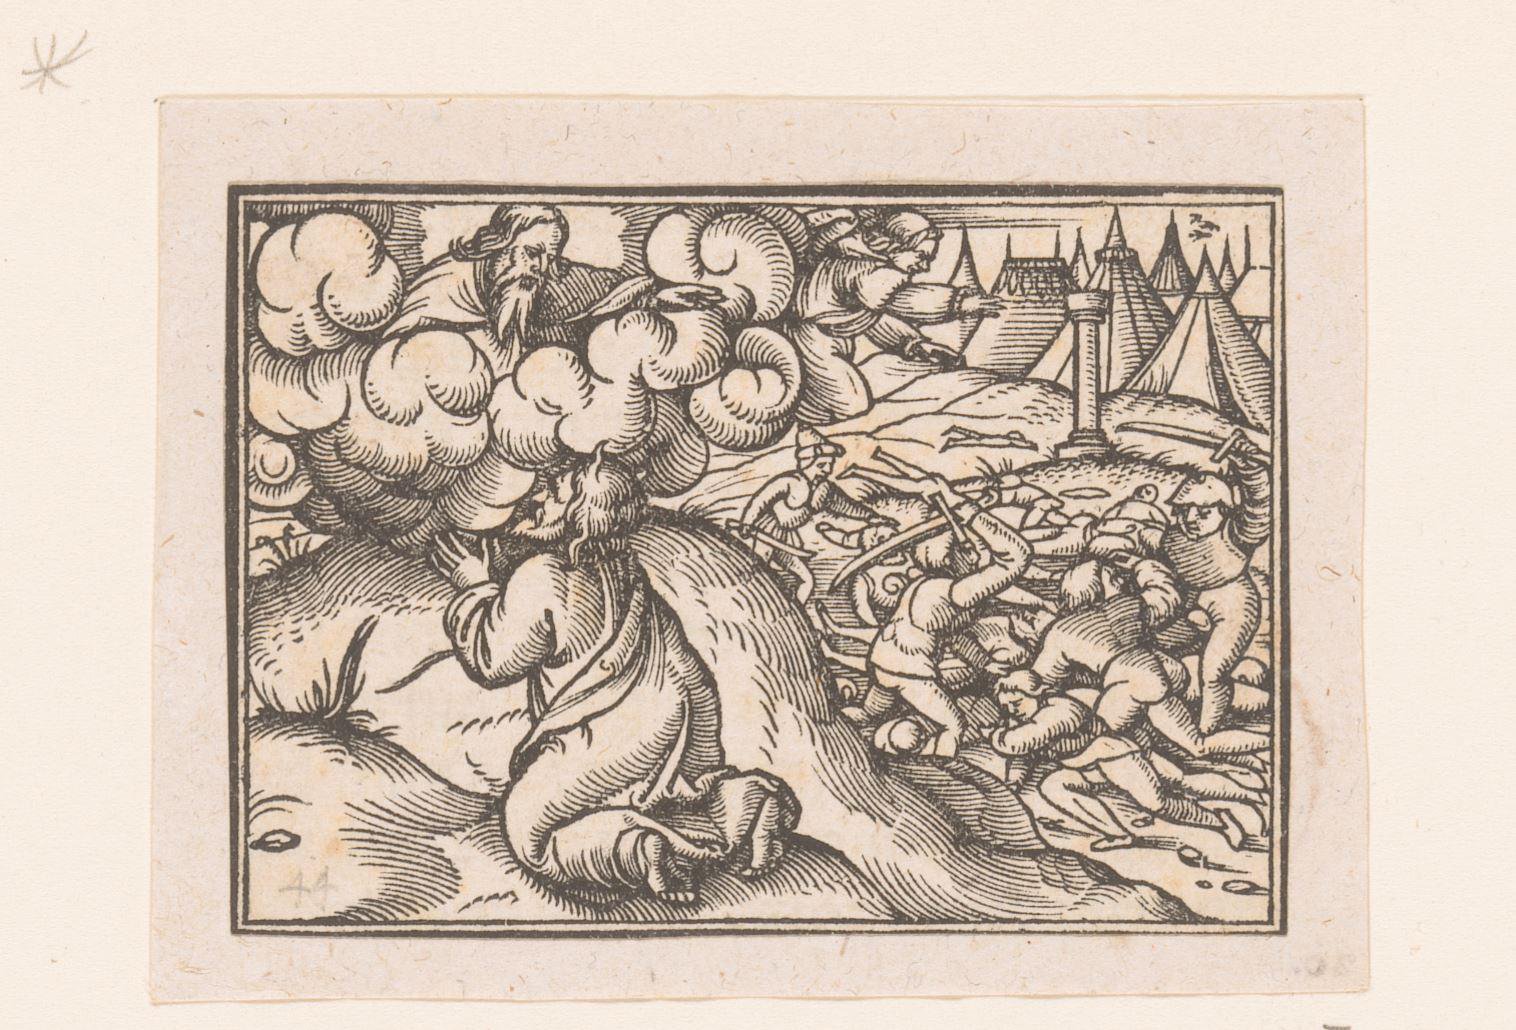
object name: book illustration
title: Mozes aanschouwt de overwinning van Saul op het leger van Amalek vanaf een heuvel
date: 1522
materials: paper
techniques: woodcut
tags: saul's war against the amalekites (1 samuel 15)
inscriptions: collector's mark: Lugt 240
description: Mogelijk een kopie van een prent van Hans Holbein de jongere. Niet uit de Icones historiarum Veteris Testamenti van 1538. Deze kopie mogelijk uit: Biblia sacra iuxta vulgatam. Parijs: Jean Benoît, 1552. Ook aanwezig in de Herzog August Bibliothek: http://diglib.hab.de?grafik=graph-res-d-326-1.